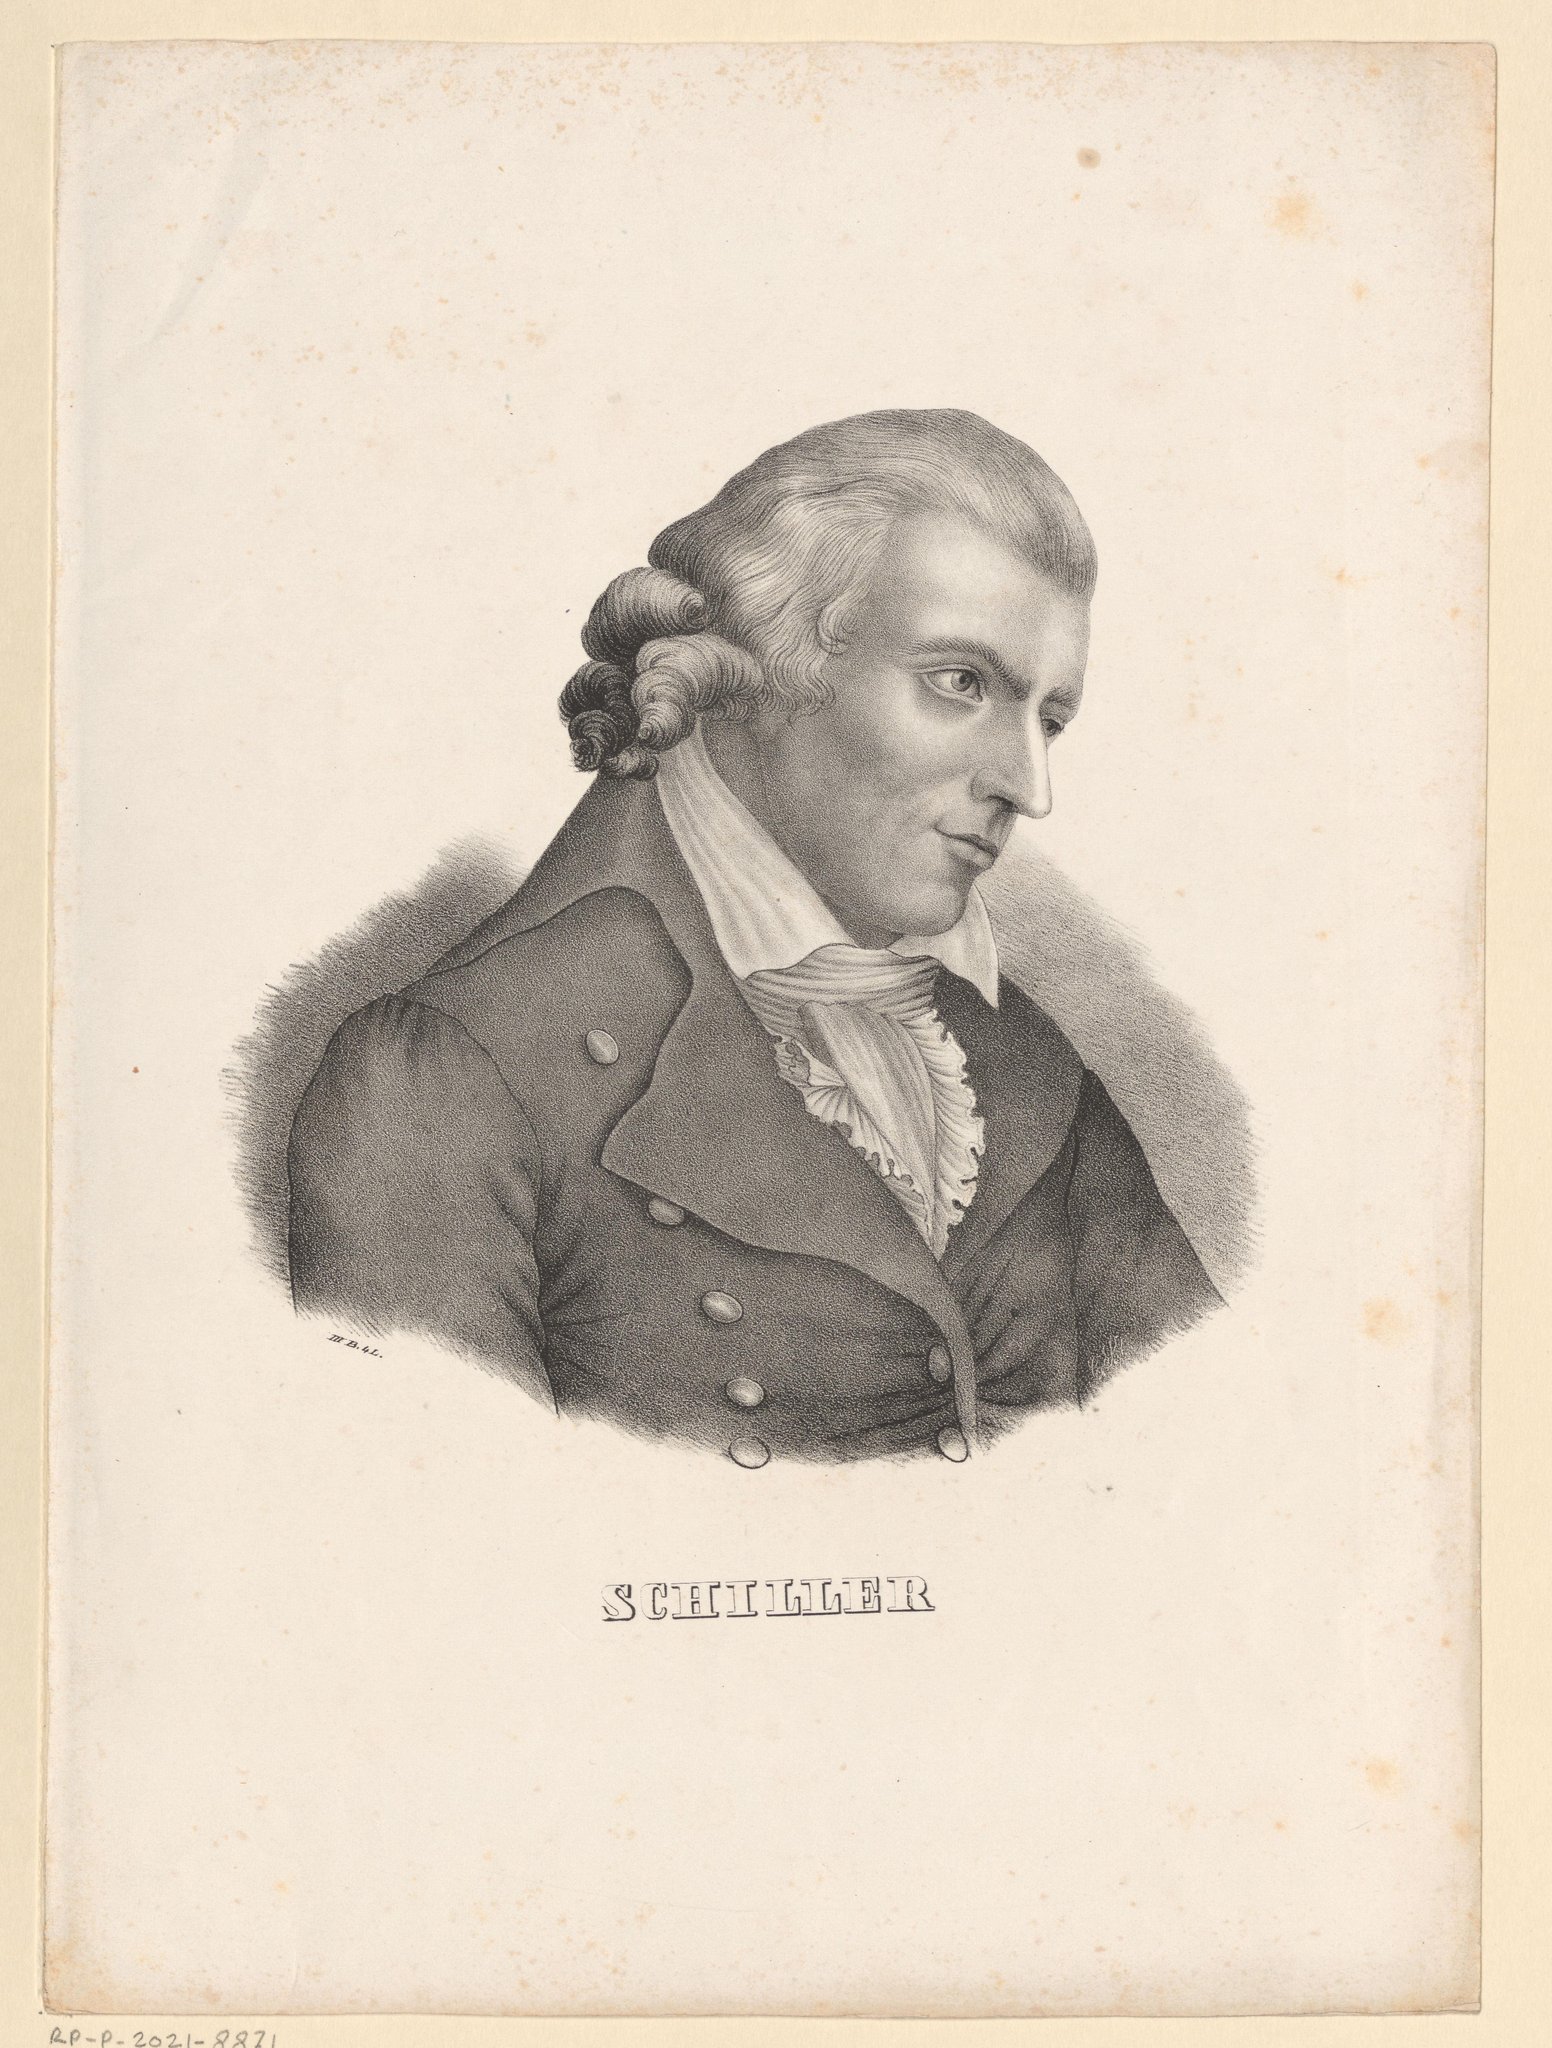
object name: print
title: Portret van Friedrich von Schiller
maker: Anonymous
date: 1800-1949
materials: paper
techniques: lithograph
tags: friedrich von schiller, scholar, philosopher, historical persons, portrait of a writer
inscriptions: monogram: ‘C[?]’